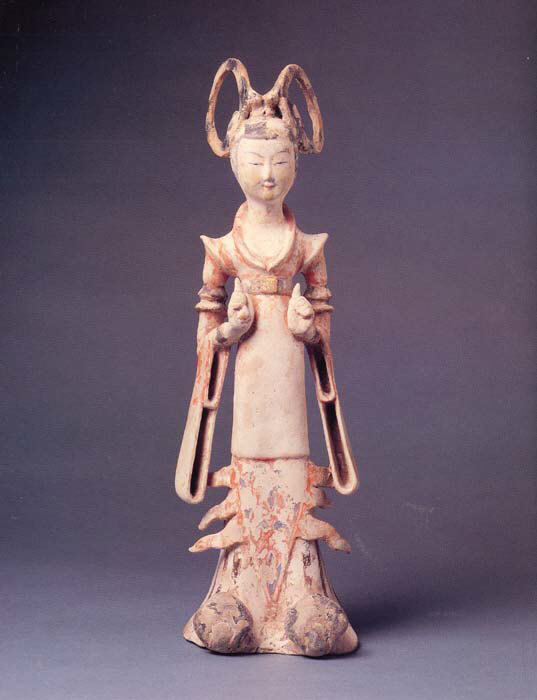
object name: figure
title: Standing court lady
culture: chinese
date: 667-700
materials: earthenware, gilt, pigment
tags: women,musicians